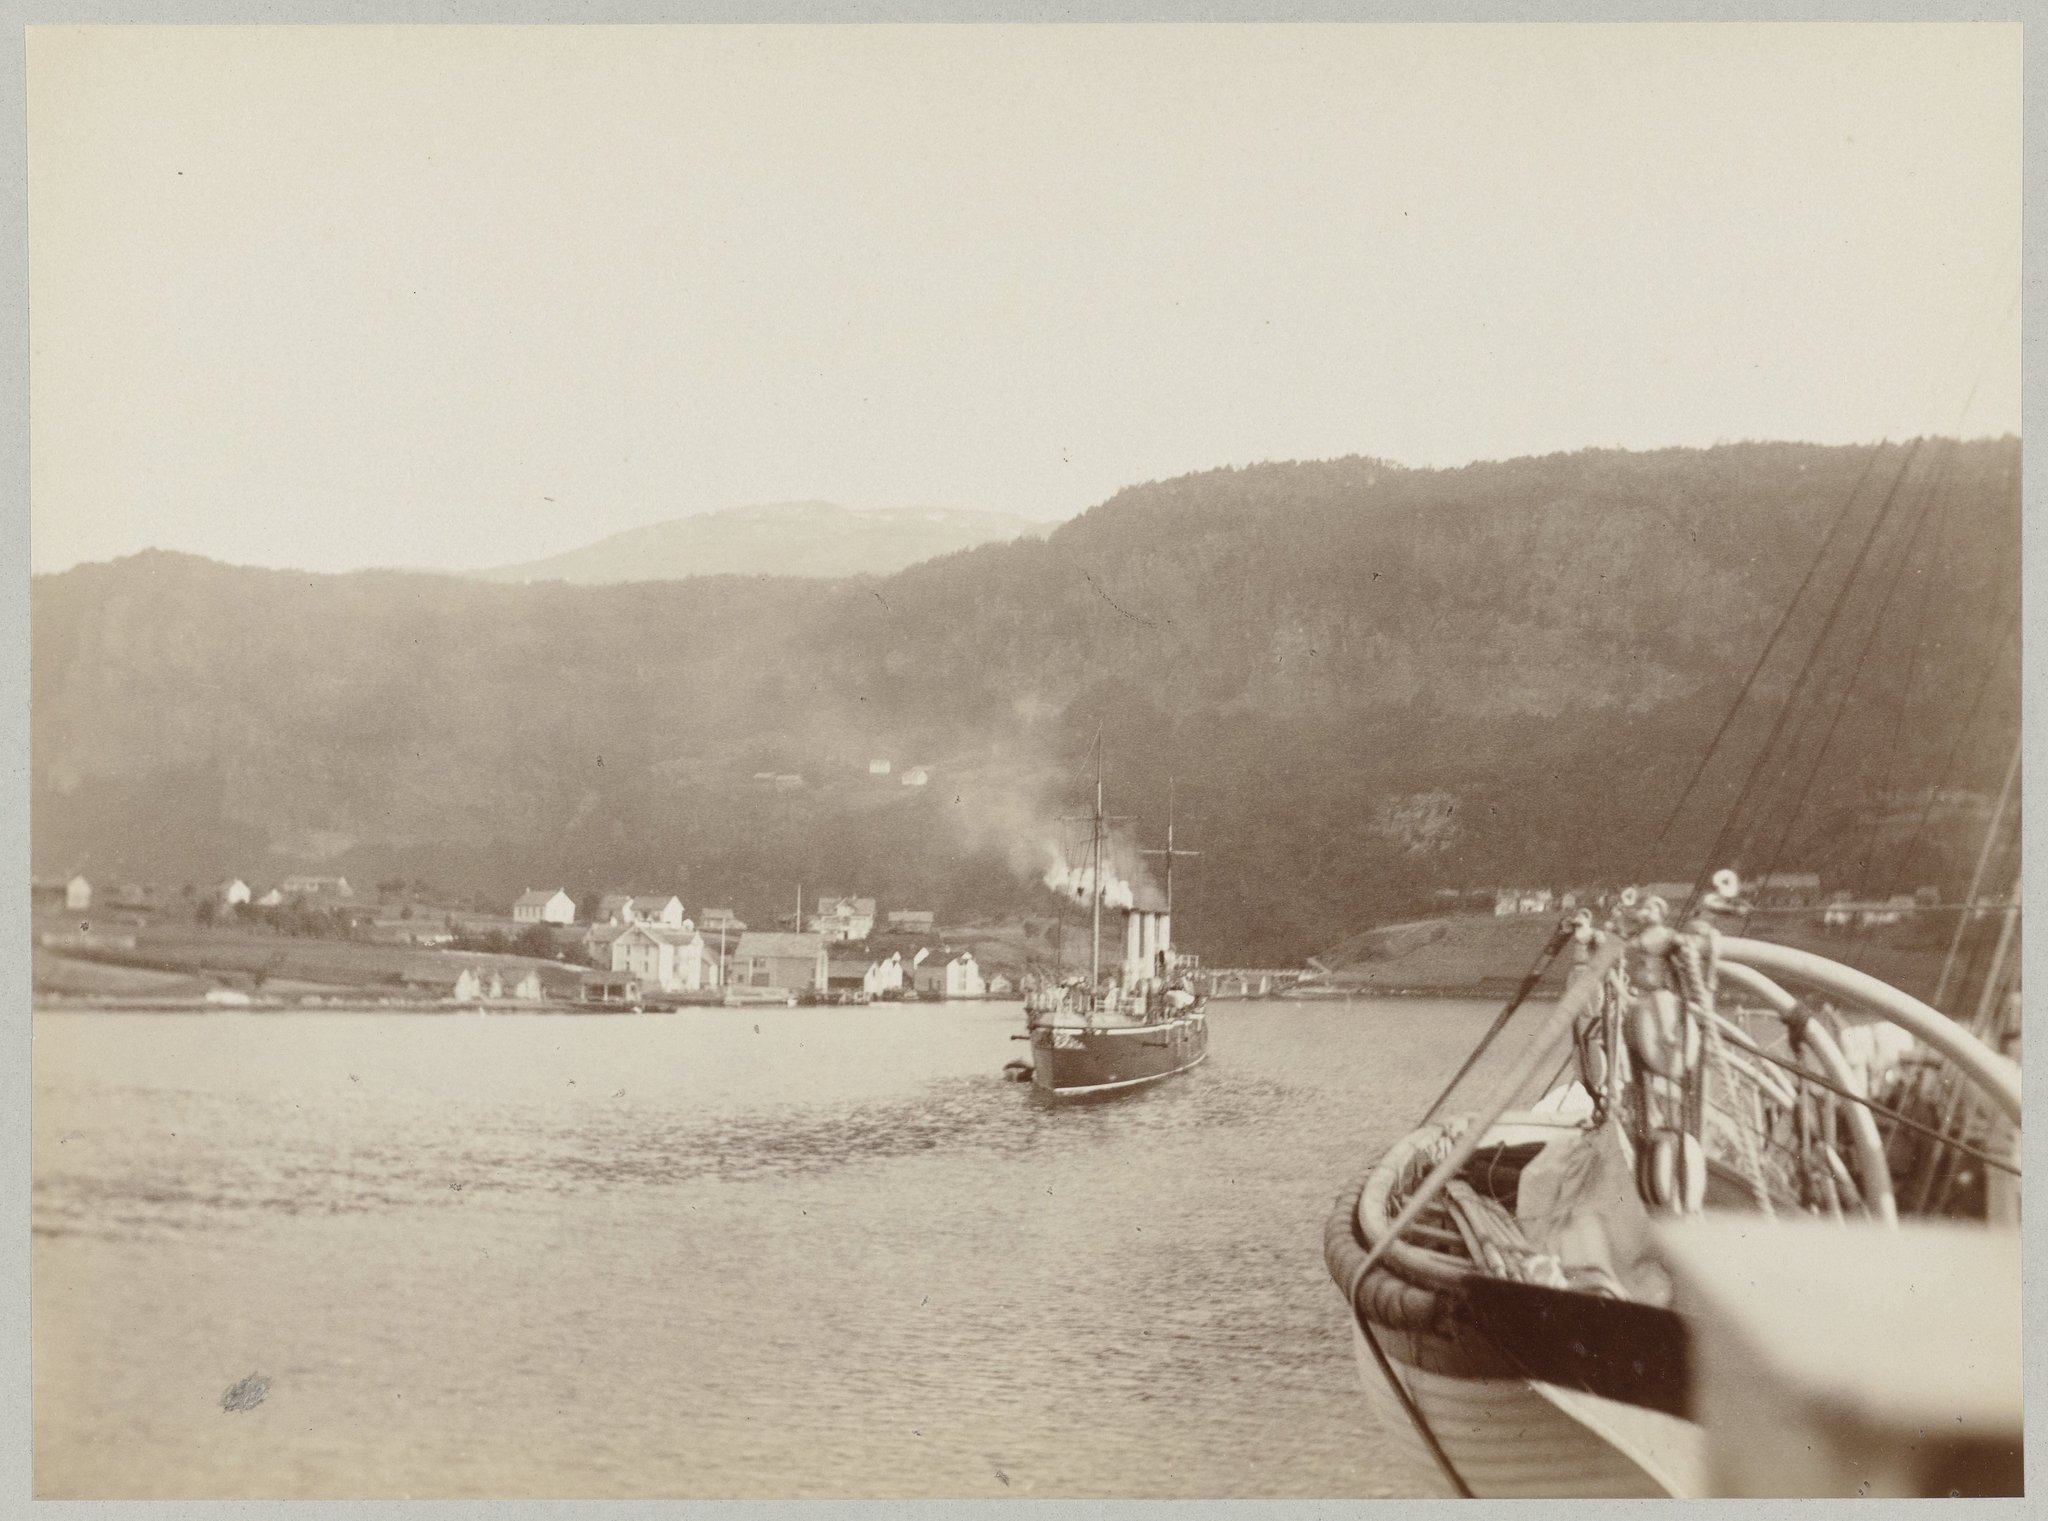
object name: photograph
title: Schip Hohenzollern vaart een haven binnen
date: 1807-1889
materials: cardboard, paper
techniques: albumen print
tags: wilhelm ii (keizer van duitsland), norway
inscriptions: number: ‘52’, number: ‘4’